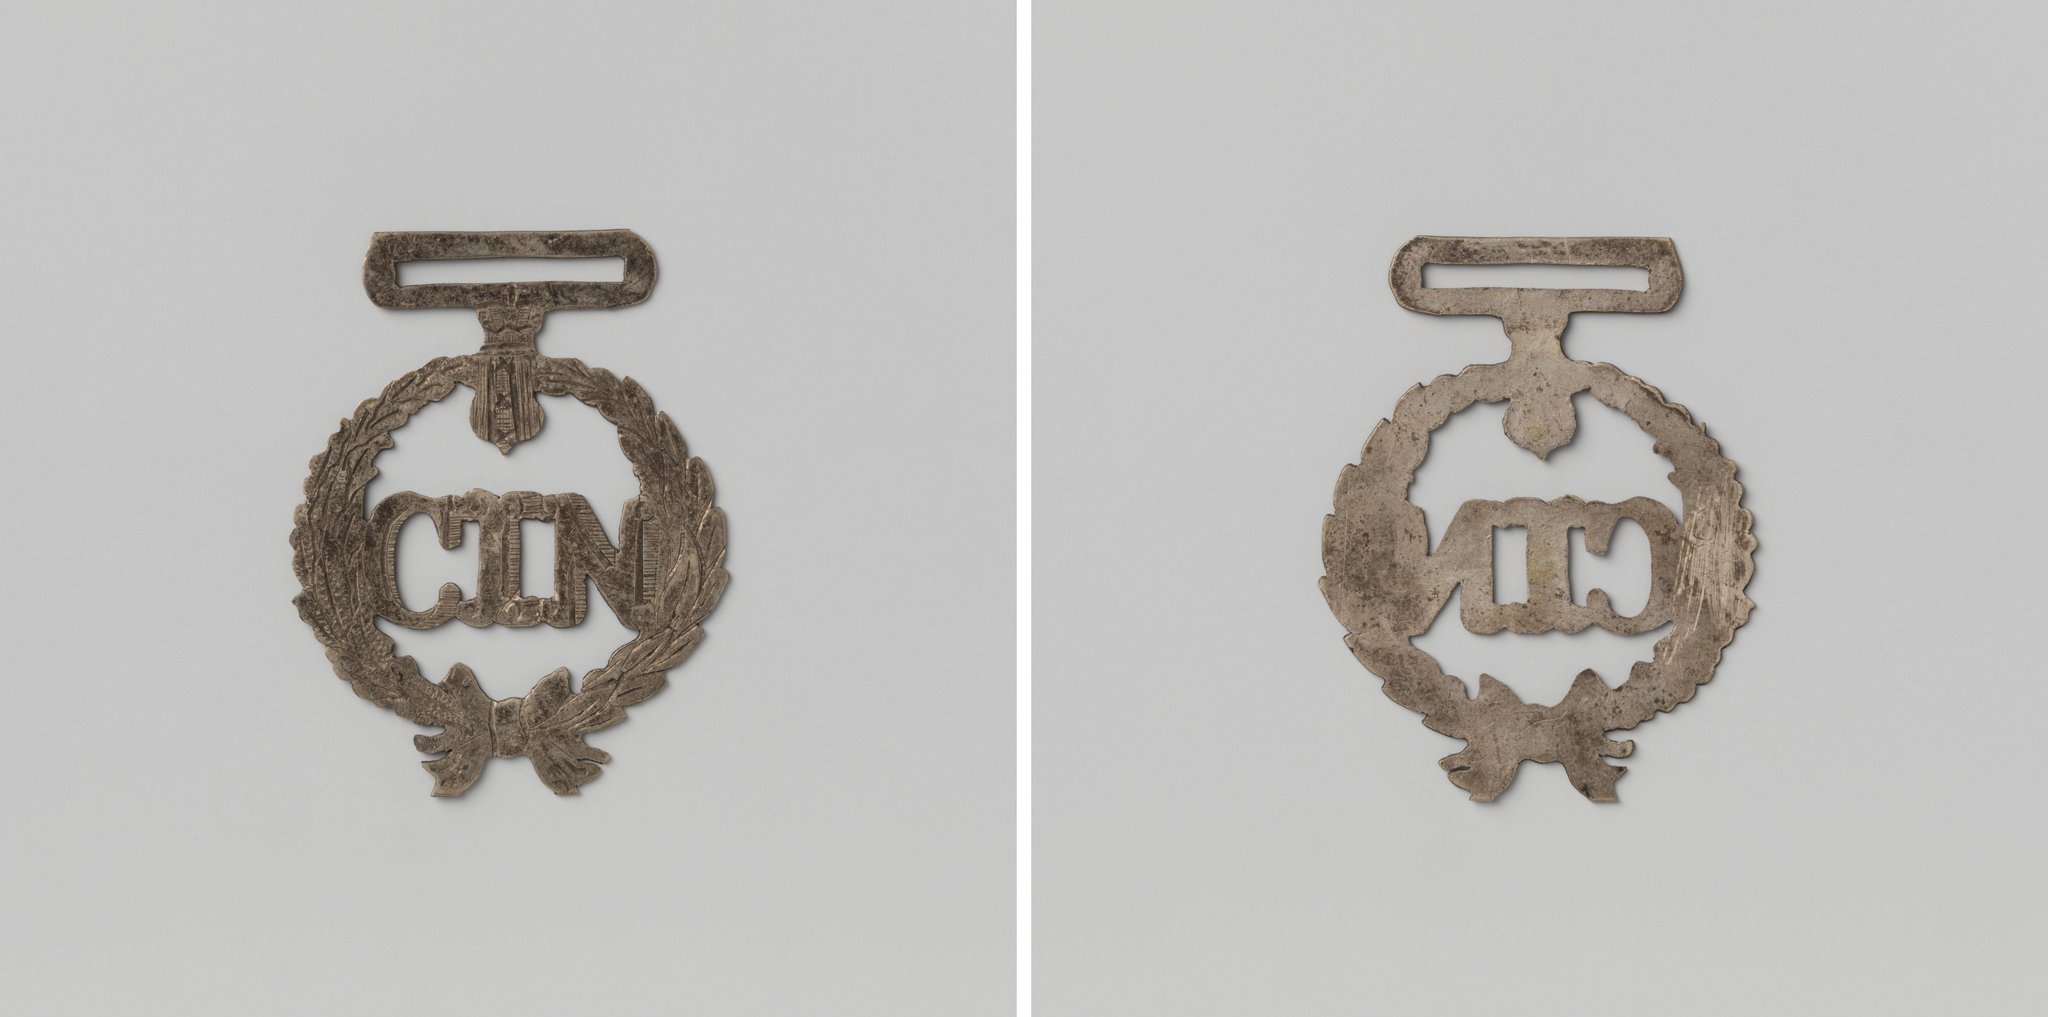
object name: insignia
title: Vereniging C.I.N. te Amsterdam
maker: Anonymous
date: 1825-1875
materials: silver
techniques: engraving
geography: amsterdam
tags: amsterdam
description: eenzijdig, opengewerkt insigne, bestaande uit letters CI en N binnen lauwerkrans, waarin zich aan bovenzijde gekroond wapenschild bevindt, waaraan langwerpig draagoog is bevestigd